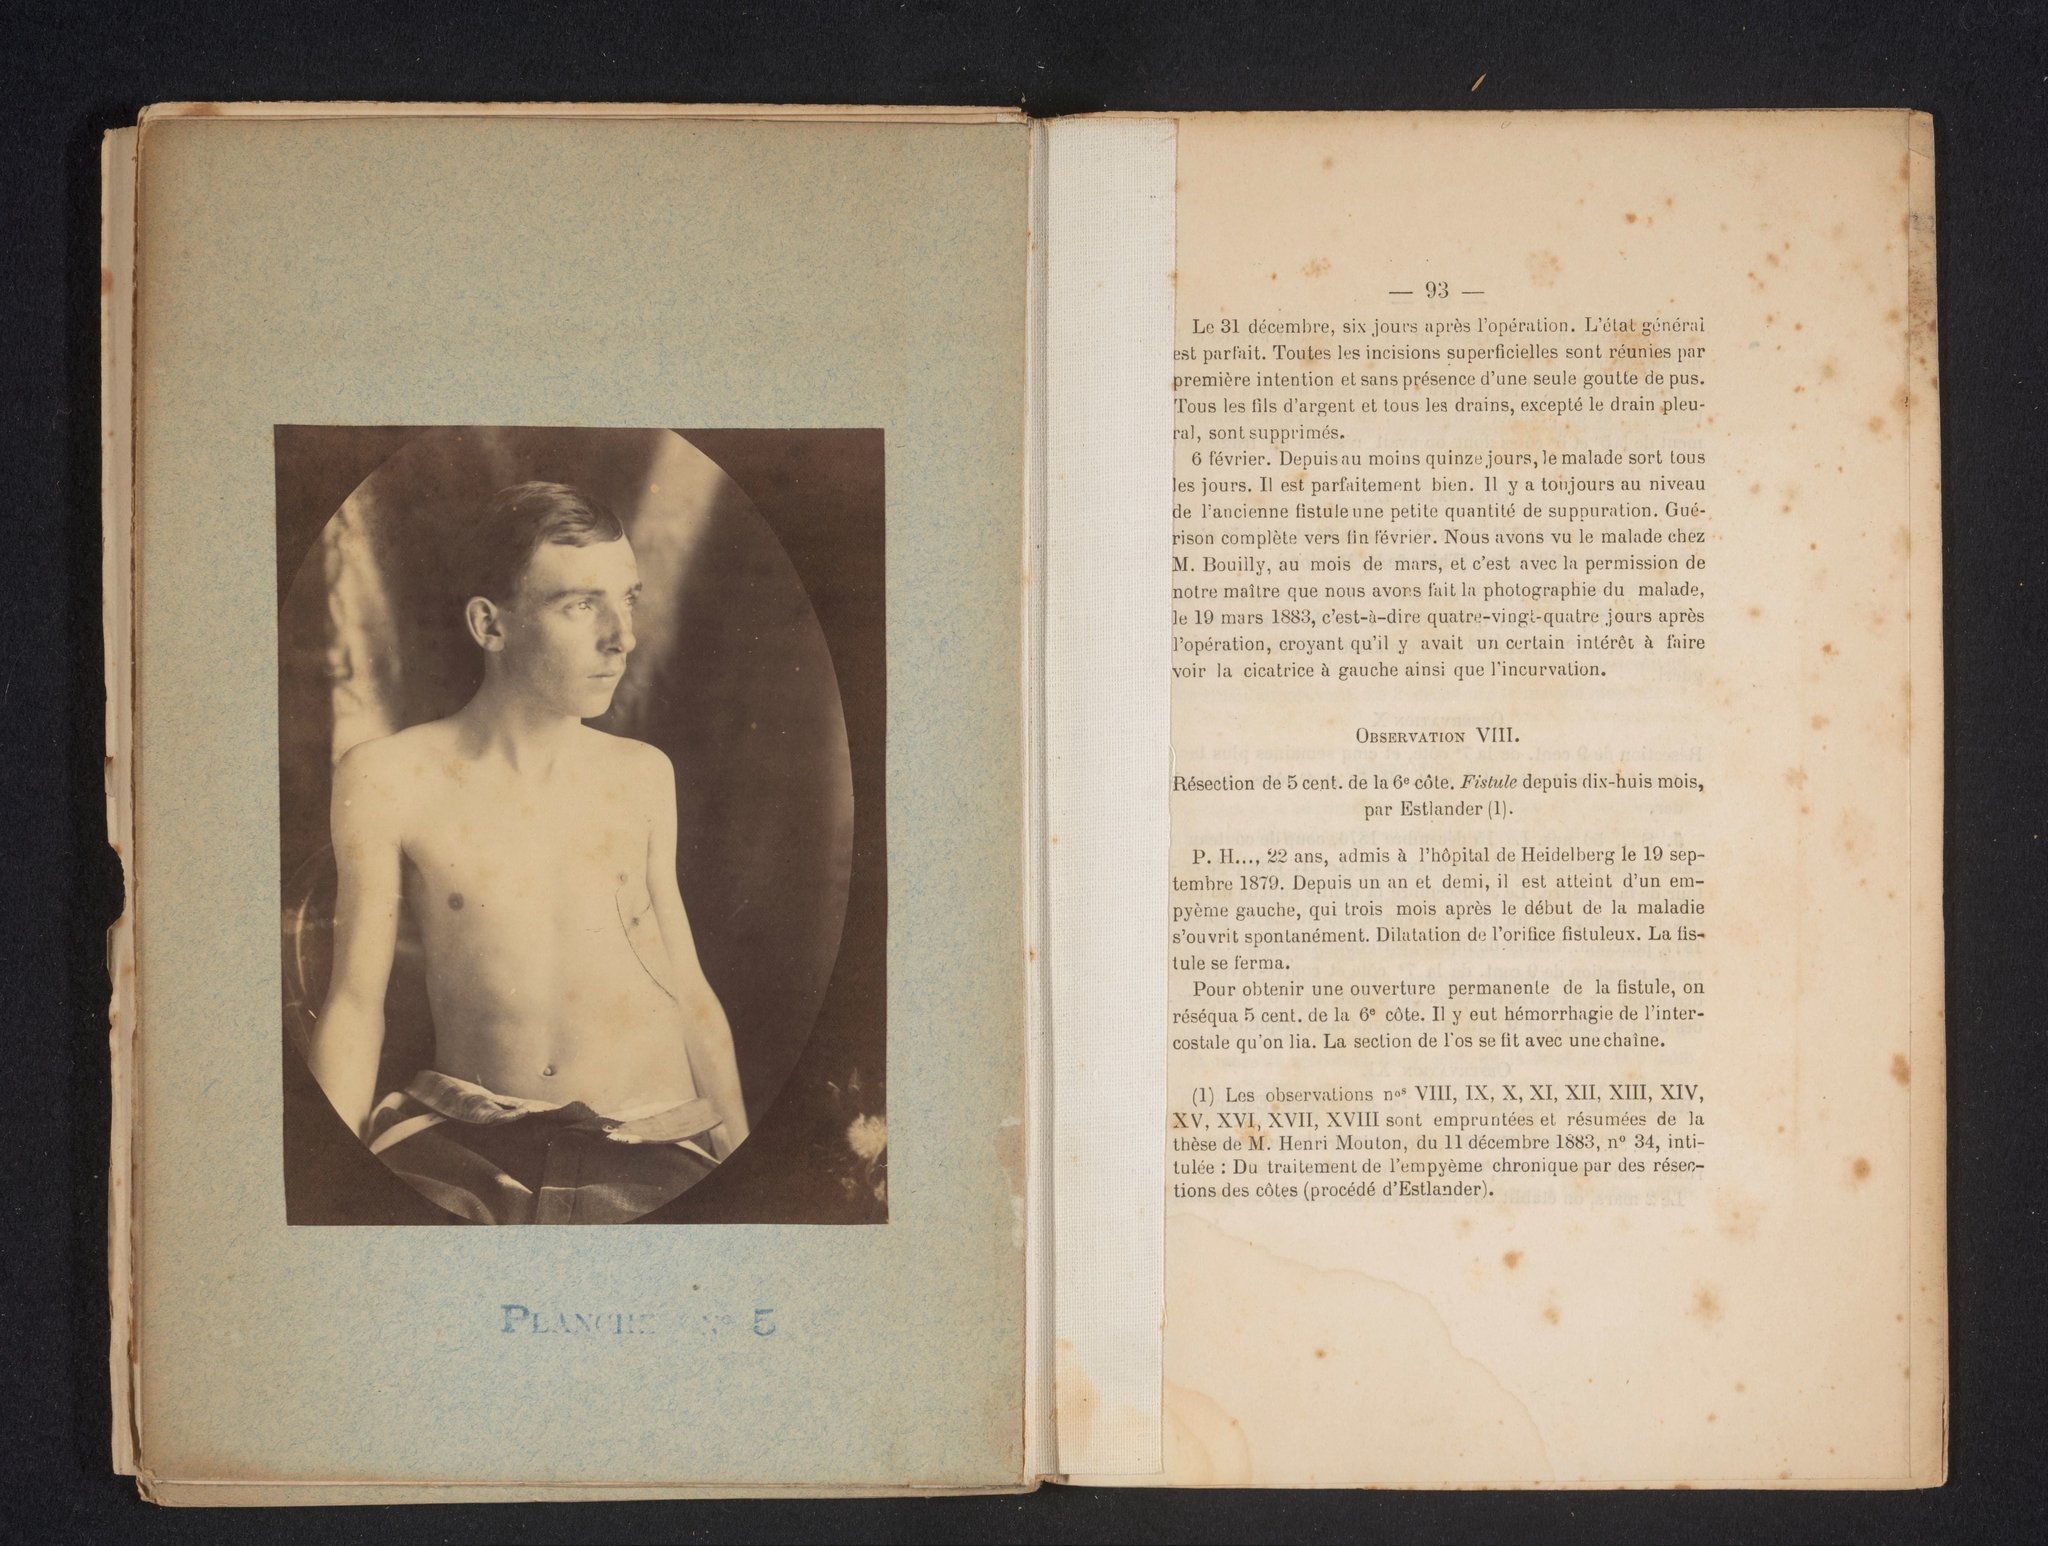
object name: page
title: Man met ontbloot bovenlijf, met een litteken aan de rechterkant van zijn borst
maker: charles edward cormack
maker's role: arts, auteur, fotograaf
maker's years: 1851-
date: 1880-1885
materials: photographic support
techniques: albumen print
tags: chest, bust, scar, cicatrix, man (showing himself) undressed, quasi-nude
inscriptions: number: ‘Planche No 5’